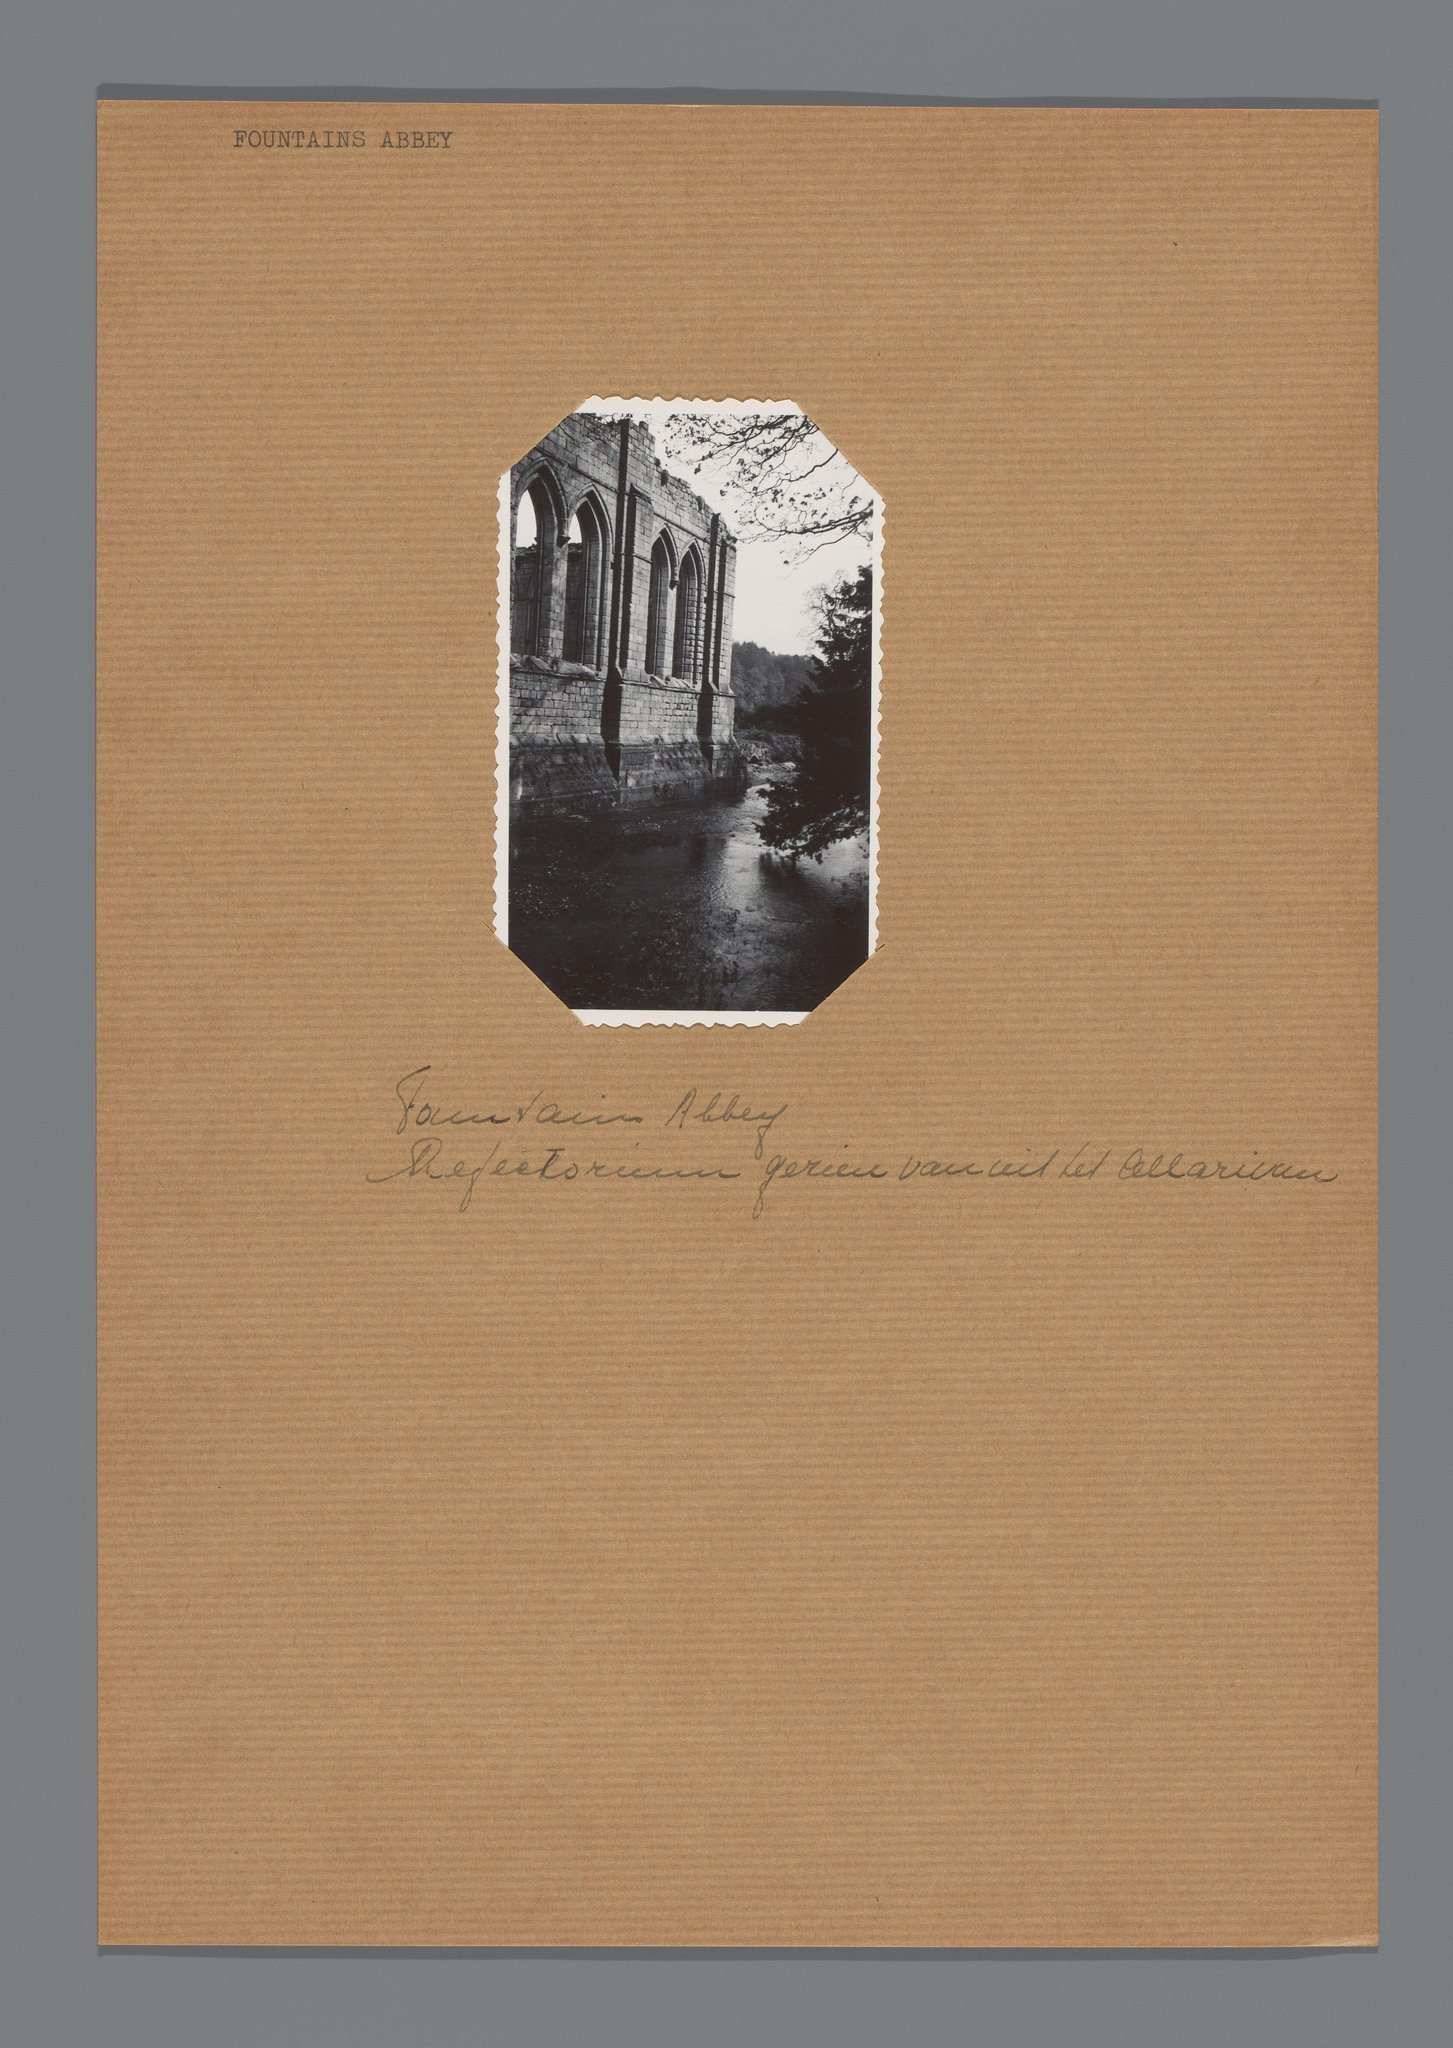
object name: photograph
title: England. Fountains Abbey.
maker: Anonymous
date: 1880-1920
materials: photographic support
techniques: gelatin silver print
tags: fountains abbey